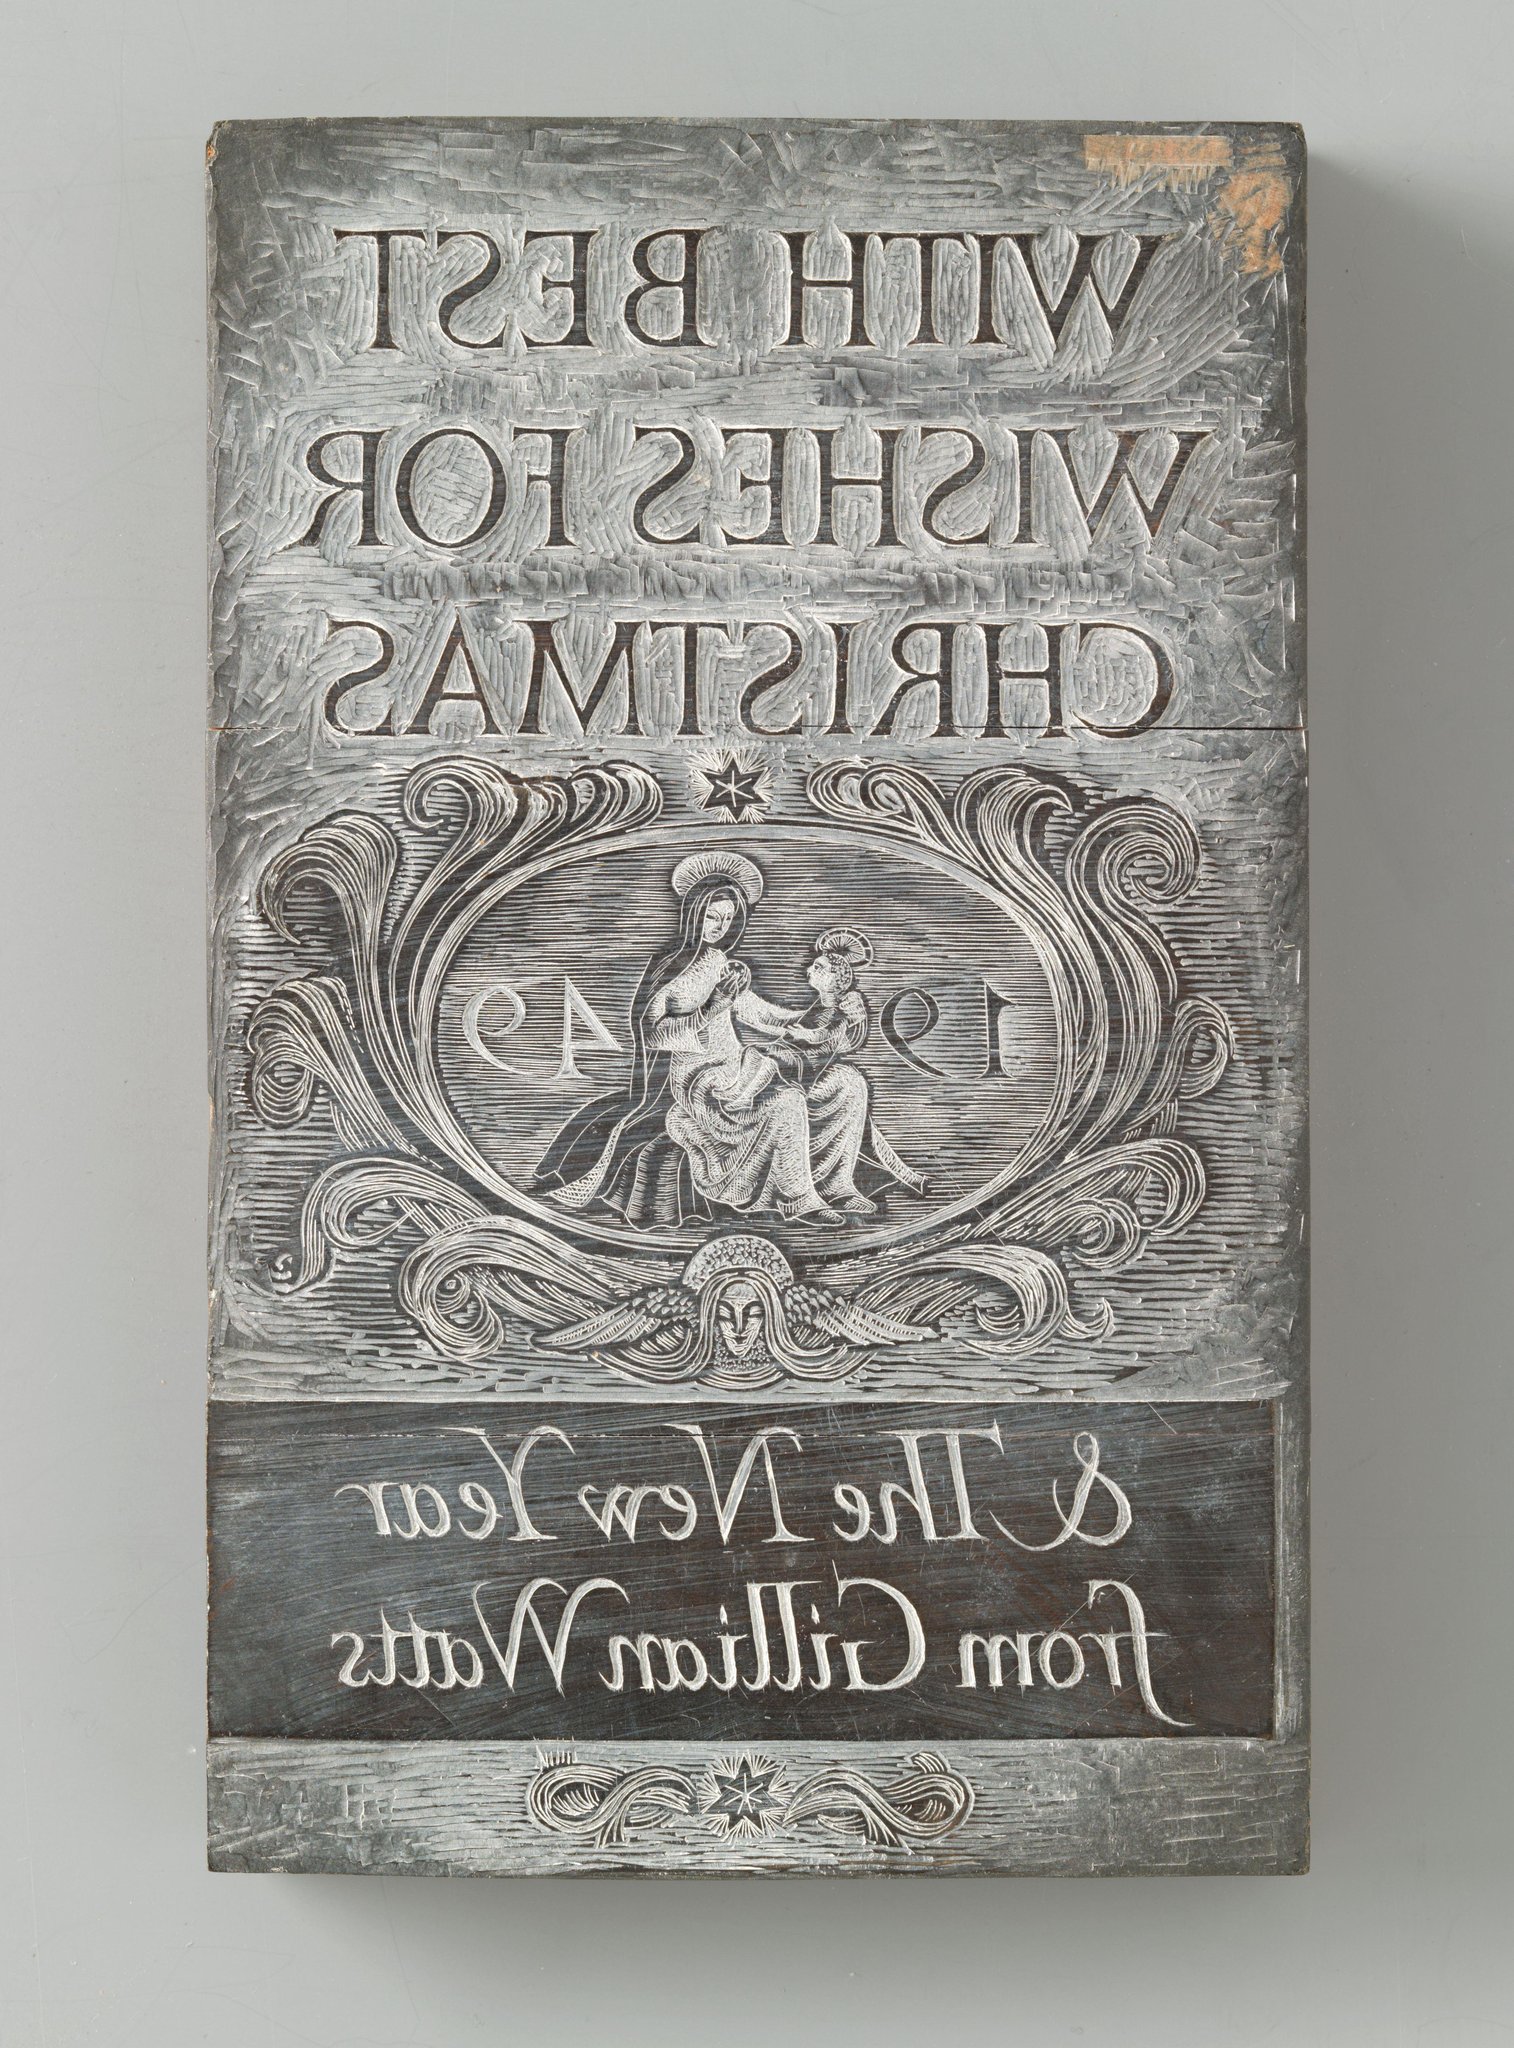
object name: wood block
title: Kerst- en nieuwjaarwens 1949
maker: Anonymous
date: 1949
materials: wood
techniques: engraving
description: Kerst- en nieuwjaarswens van Gillian Watts.